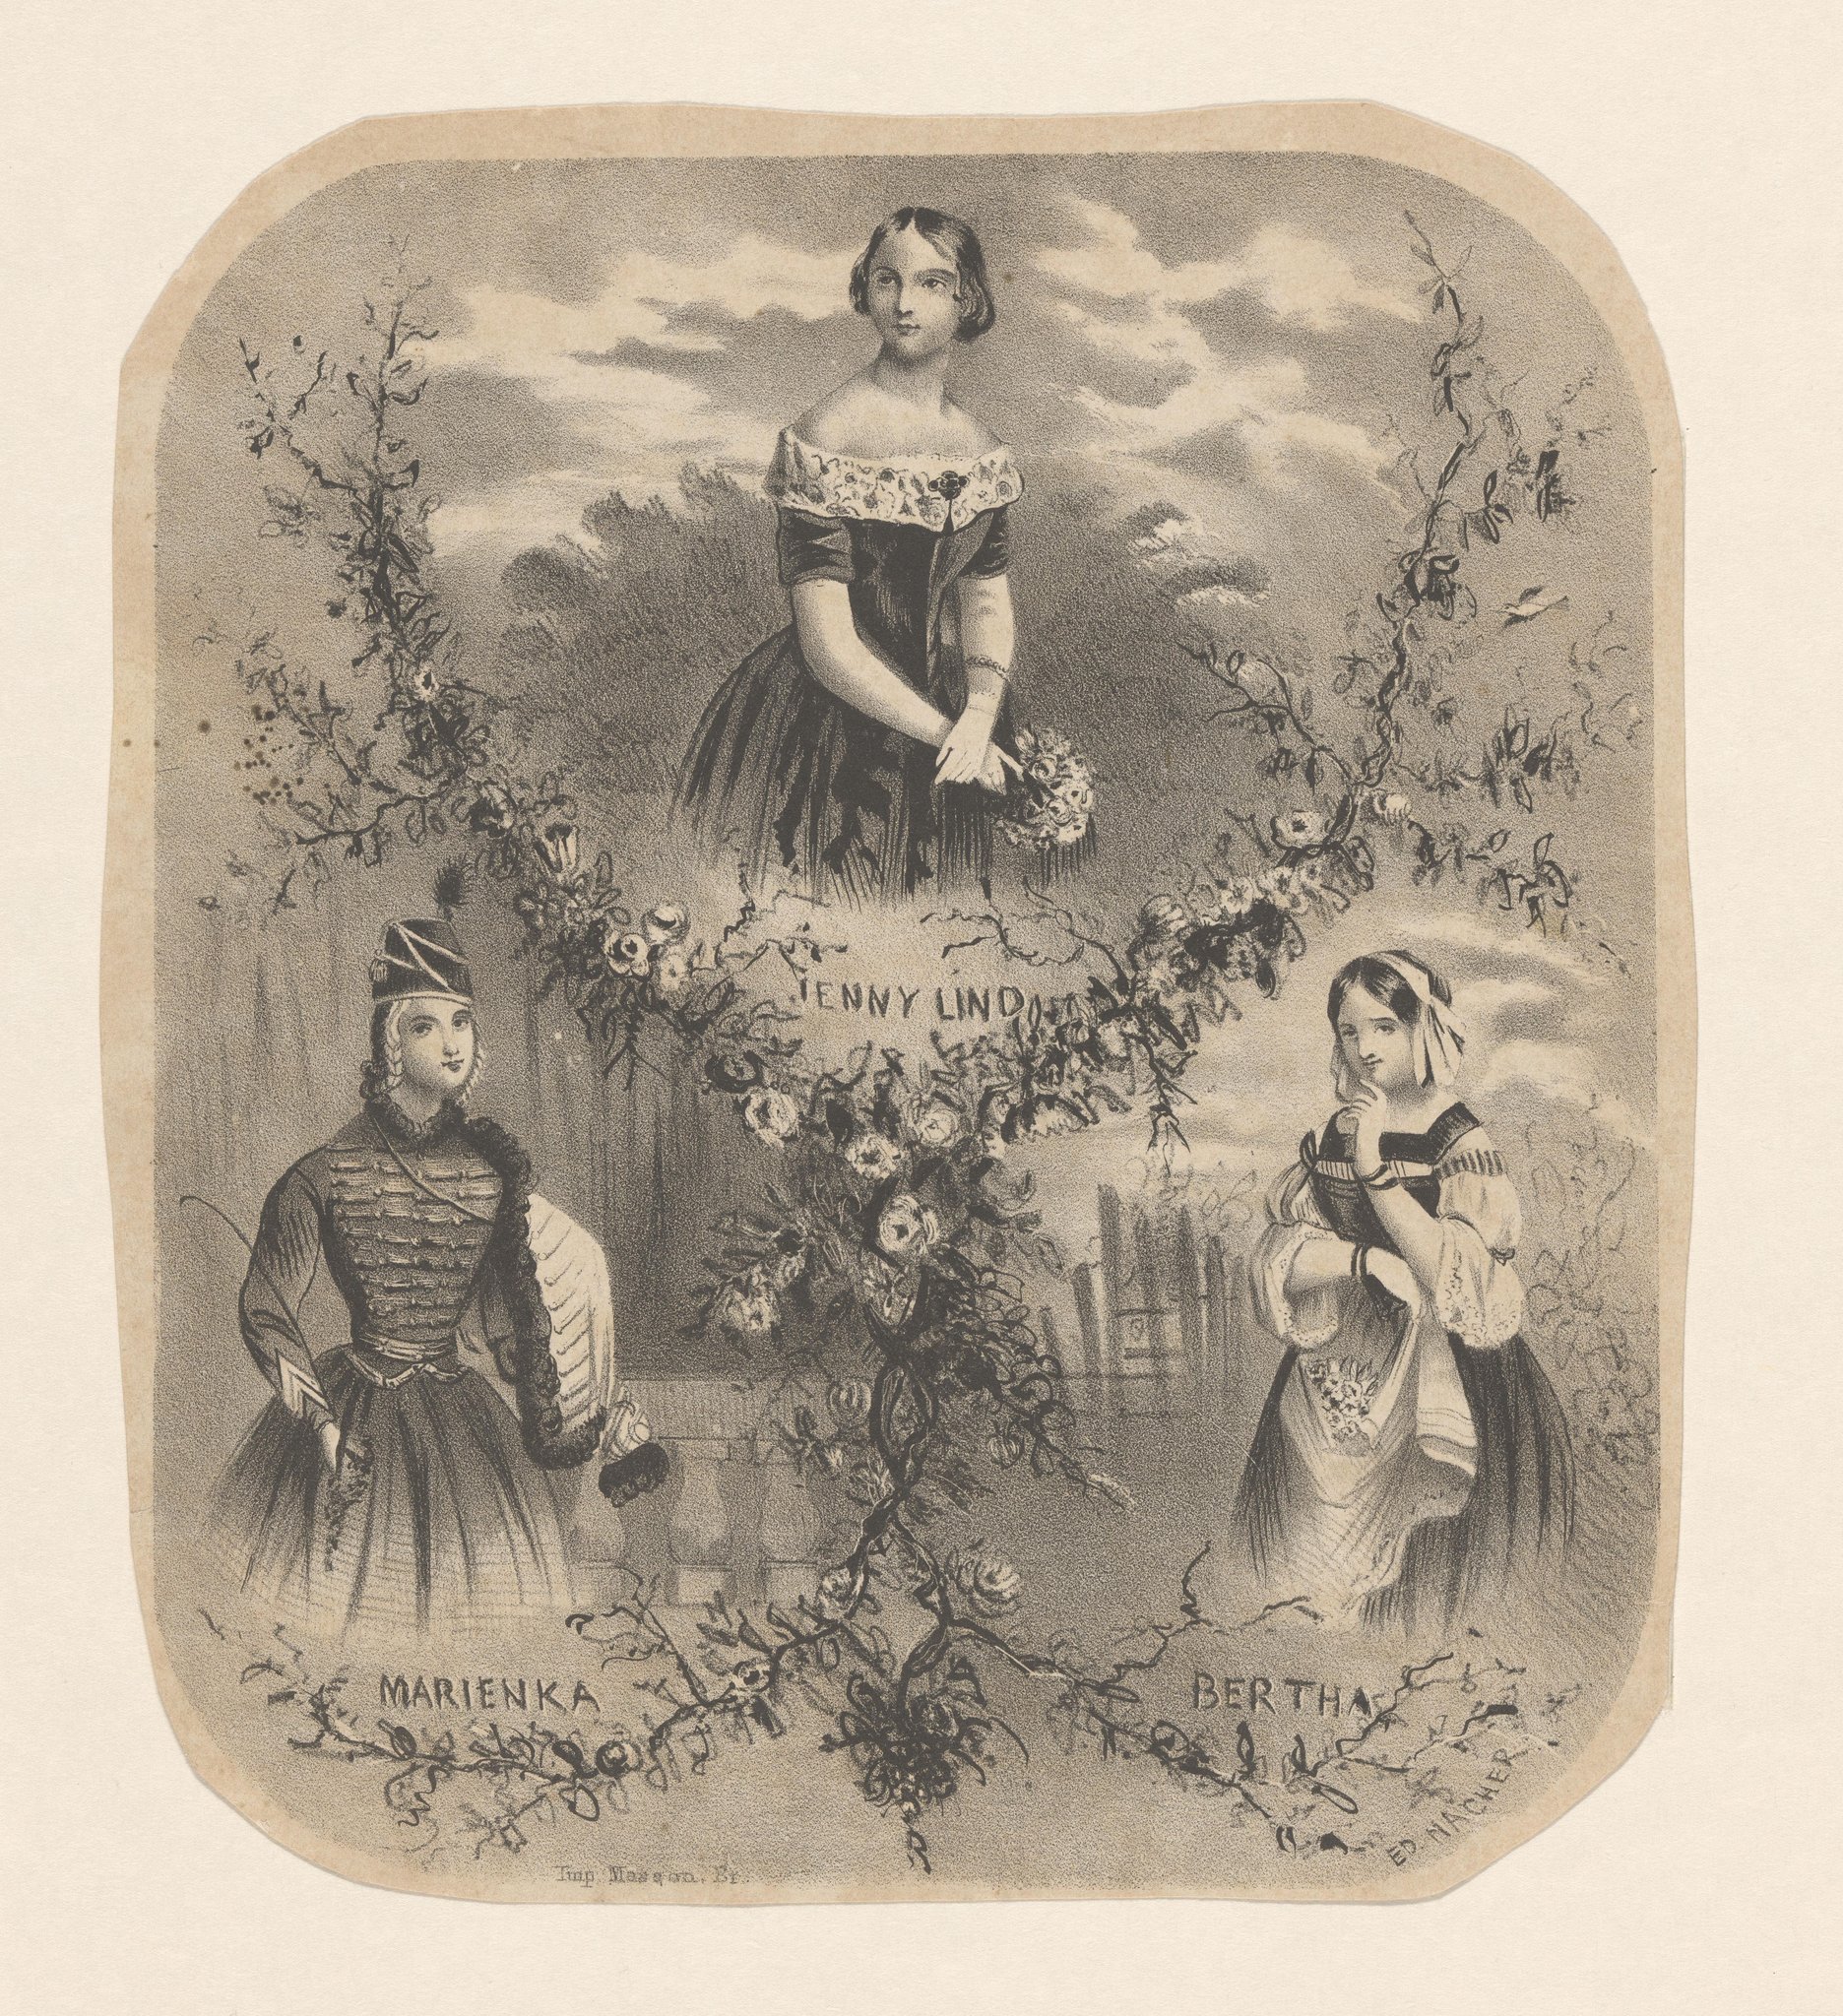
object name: print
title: Portretten van Jenny Lind, Marienka en Bertha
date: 1850-1890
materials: paper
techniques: lithograph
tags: historical persons, adult woman (+ three persons), female singer